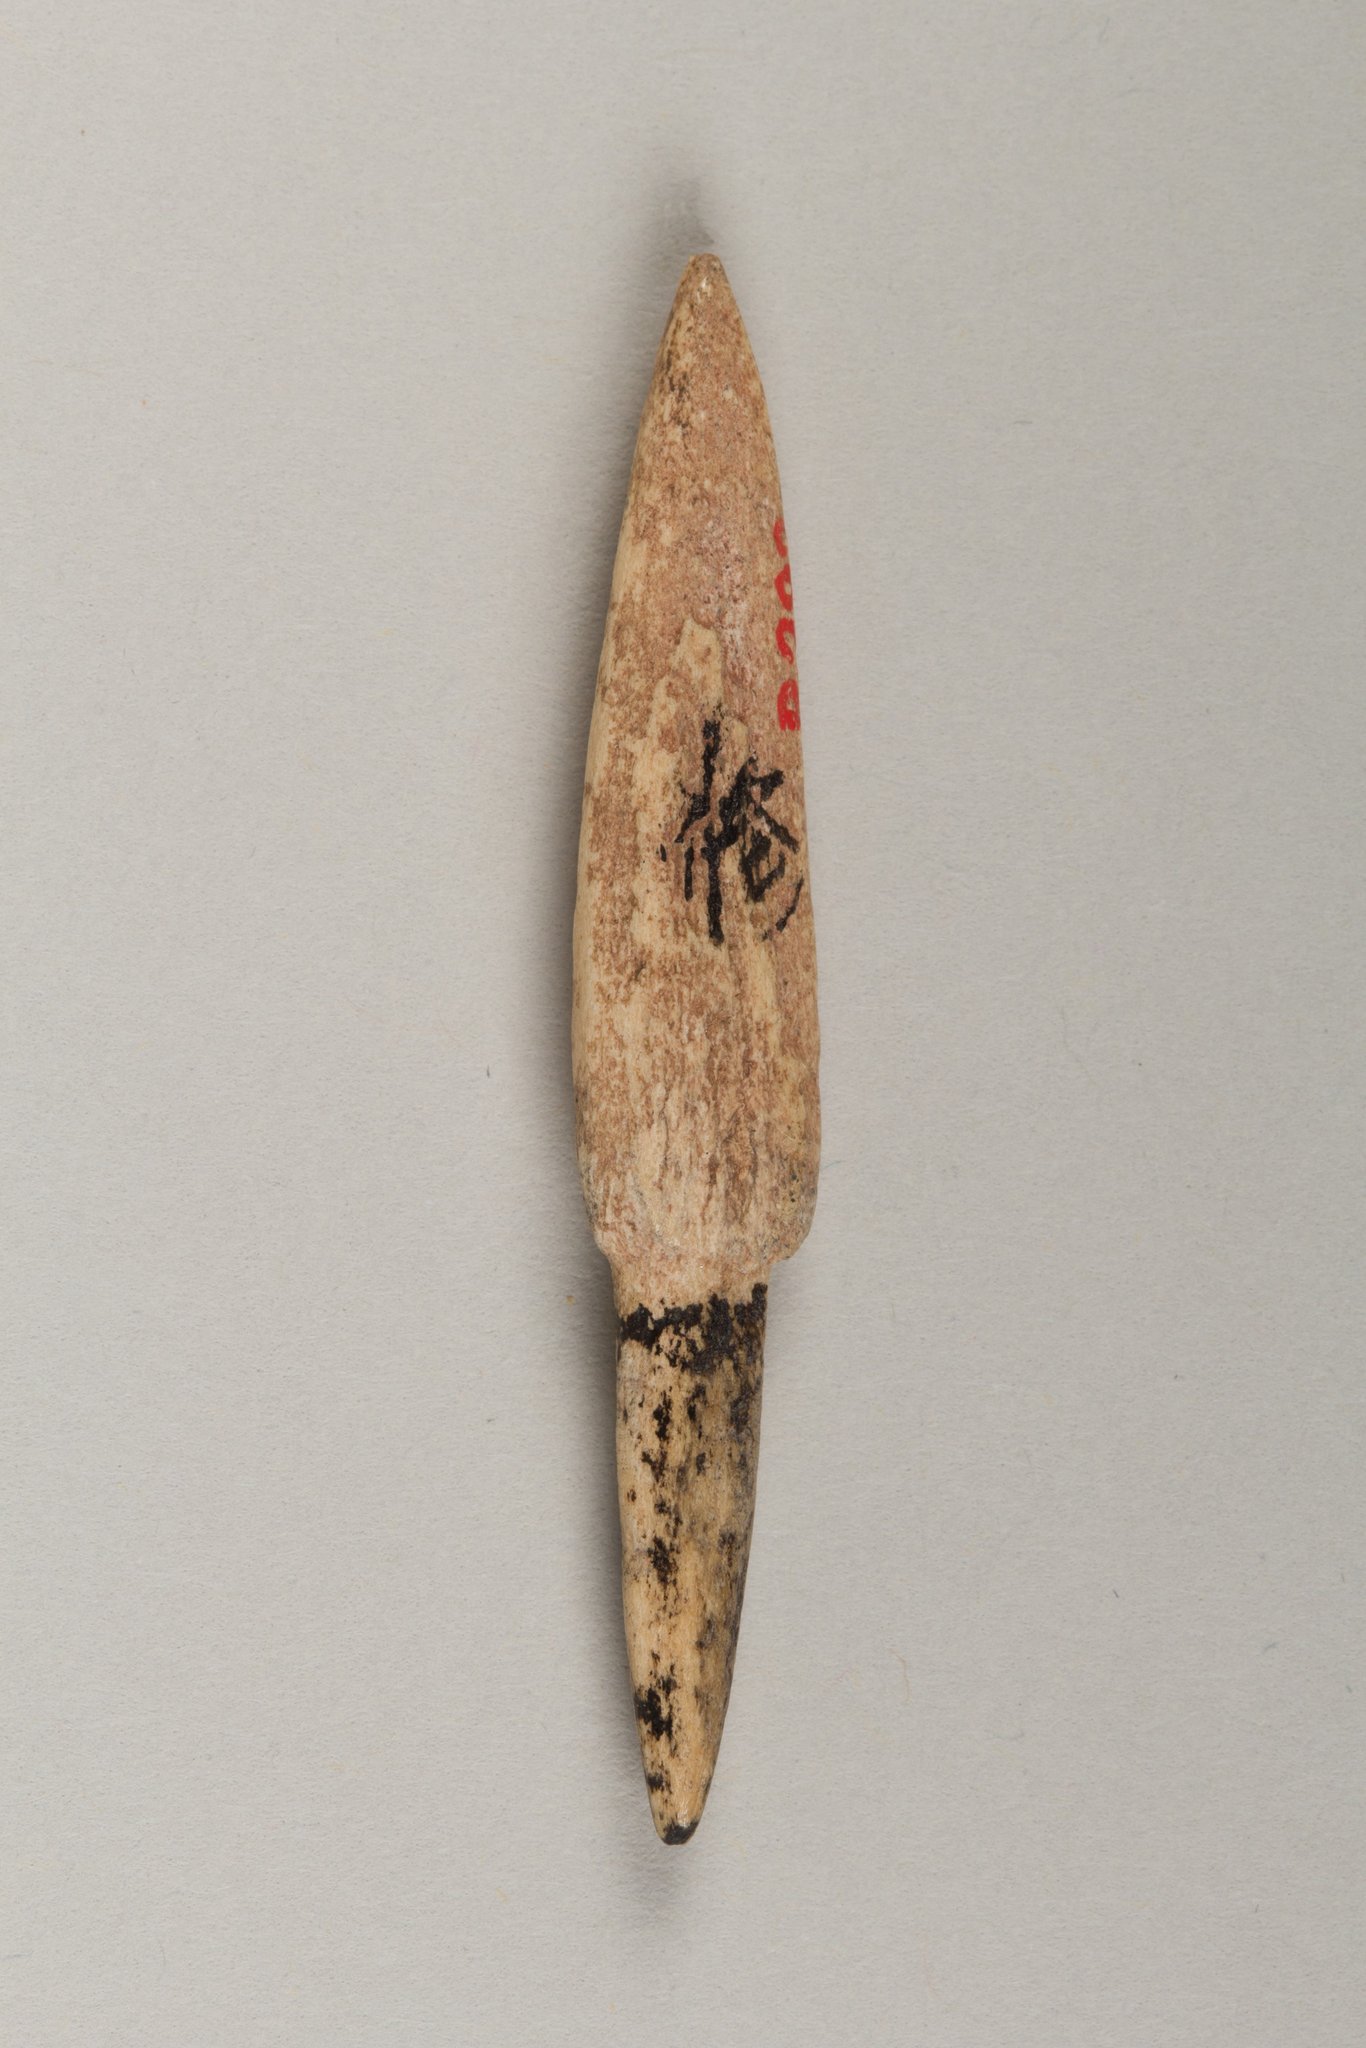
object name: arrowhead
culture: japanese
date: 1000-300 BCE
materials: bone